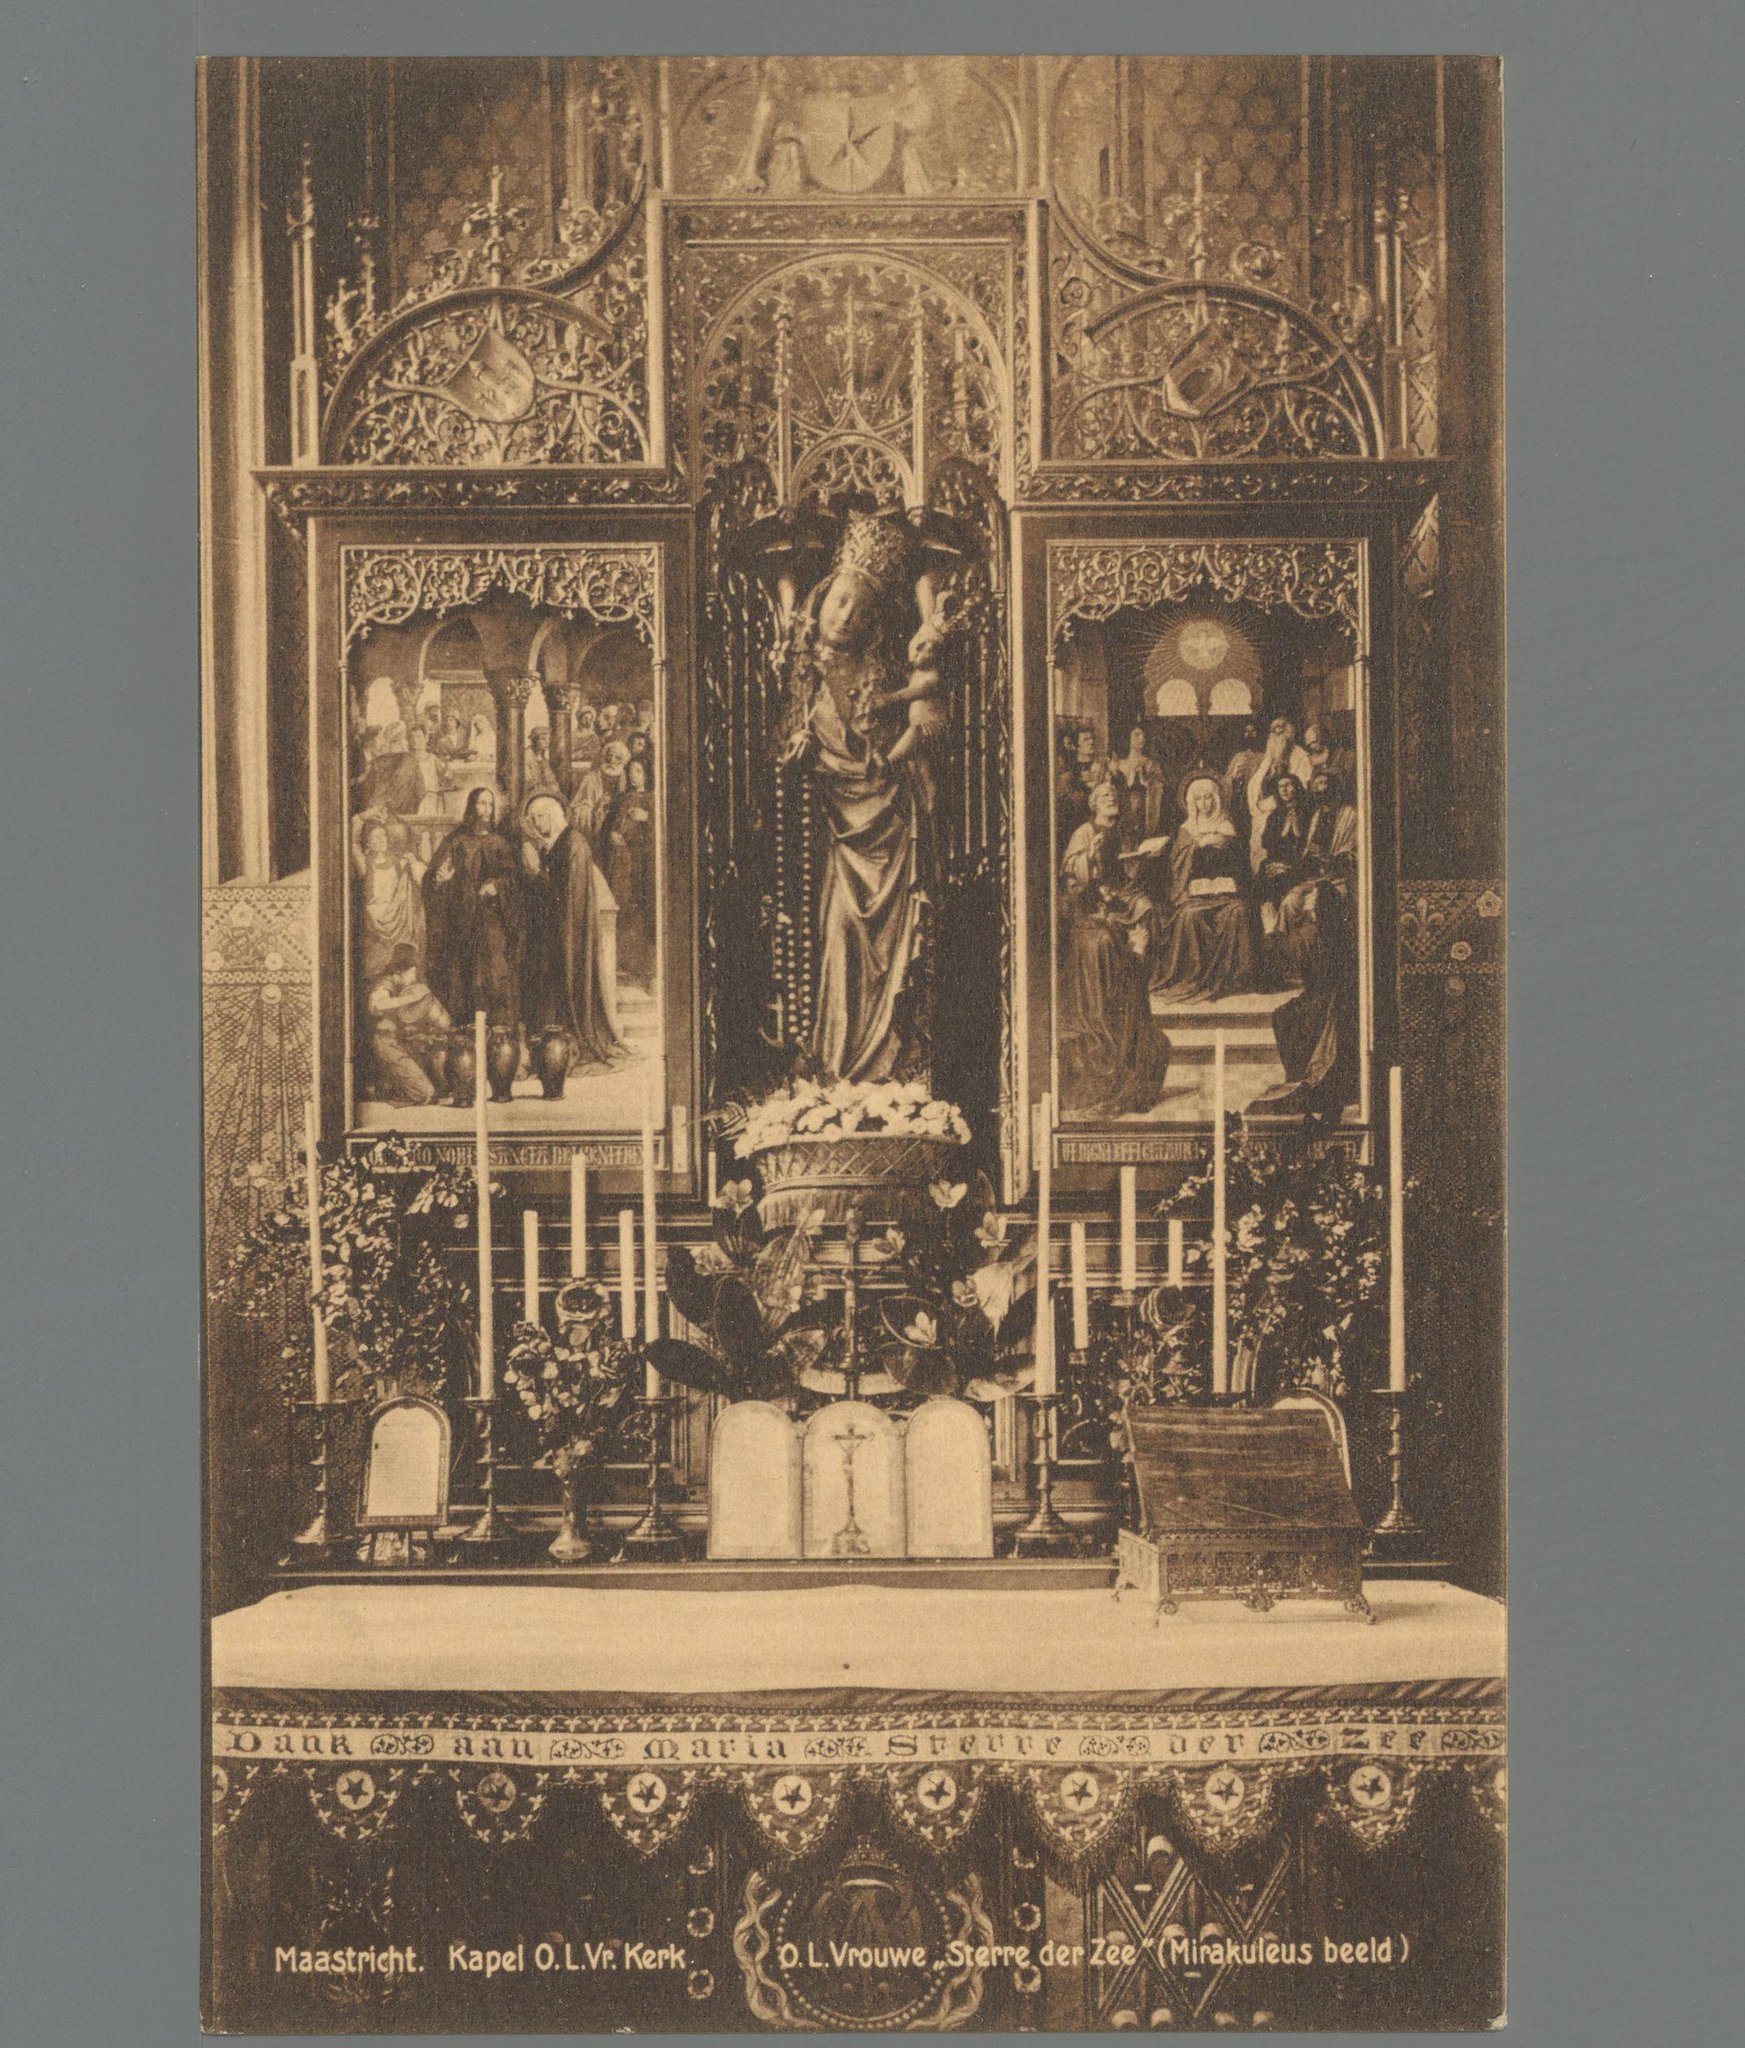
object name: ansichtkaart, prentbriefkaart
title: Maastricht. Kapel O.L.Vr. Kerk. O.L.Vrouwe "Sterre der Zee"(mirakuleus beeld)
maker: Anonymous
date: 1912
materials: cardboard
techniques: photograph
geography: maastricht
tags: monument, statue, parts of church interior: chapel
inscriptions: date